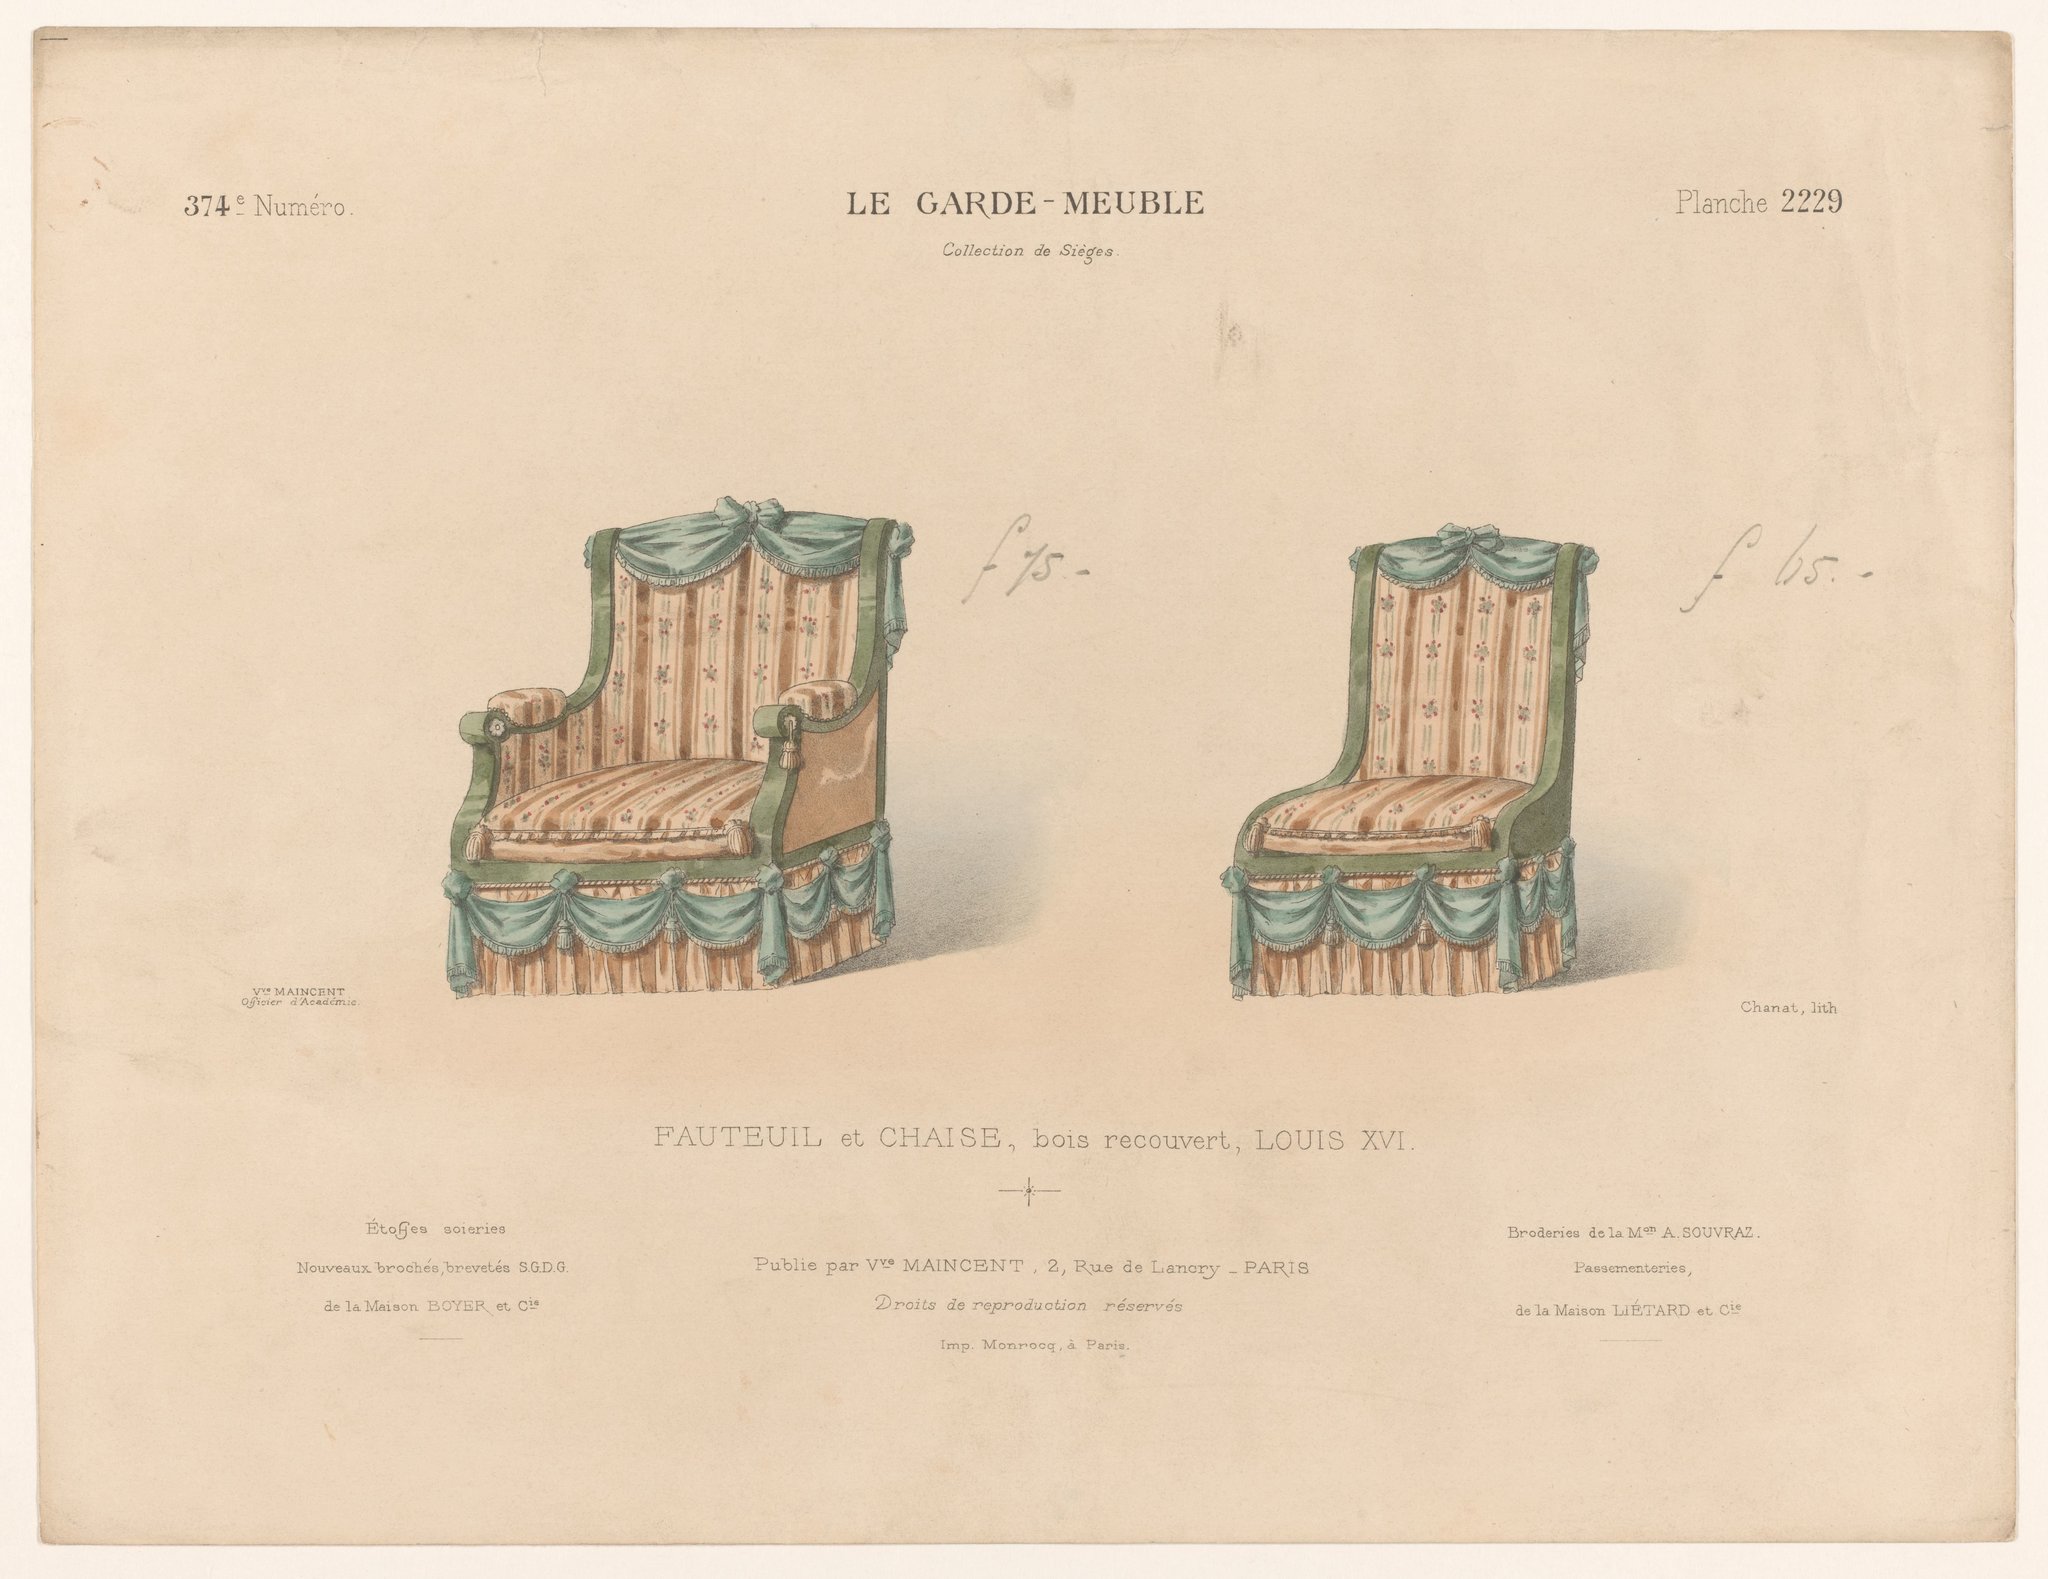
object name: print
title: Fauteuil en stoel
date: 1895-1935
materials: paper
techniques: hand coloring, lithograph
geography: paris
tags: seating furniture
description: Ieder Livraison in de serie Le Garde-Meuble bevat negen platen: drie 'sièges' (zitmeubels), drie 'meubles' (diverse meubels zoals tafels en kasten) en drie 'tentures' (gordijnen en draperieën).